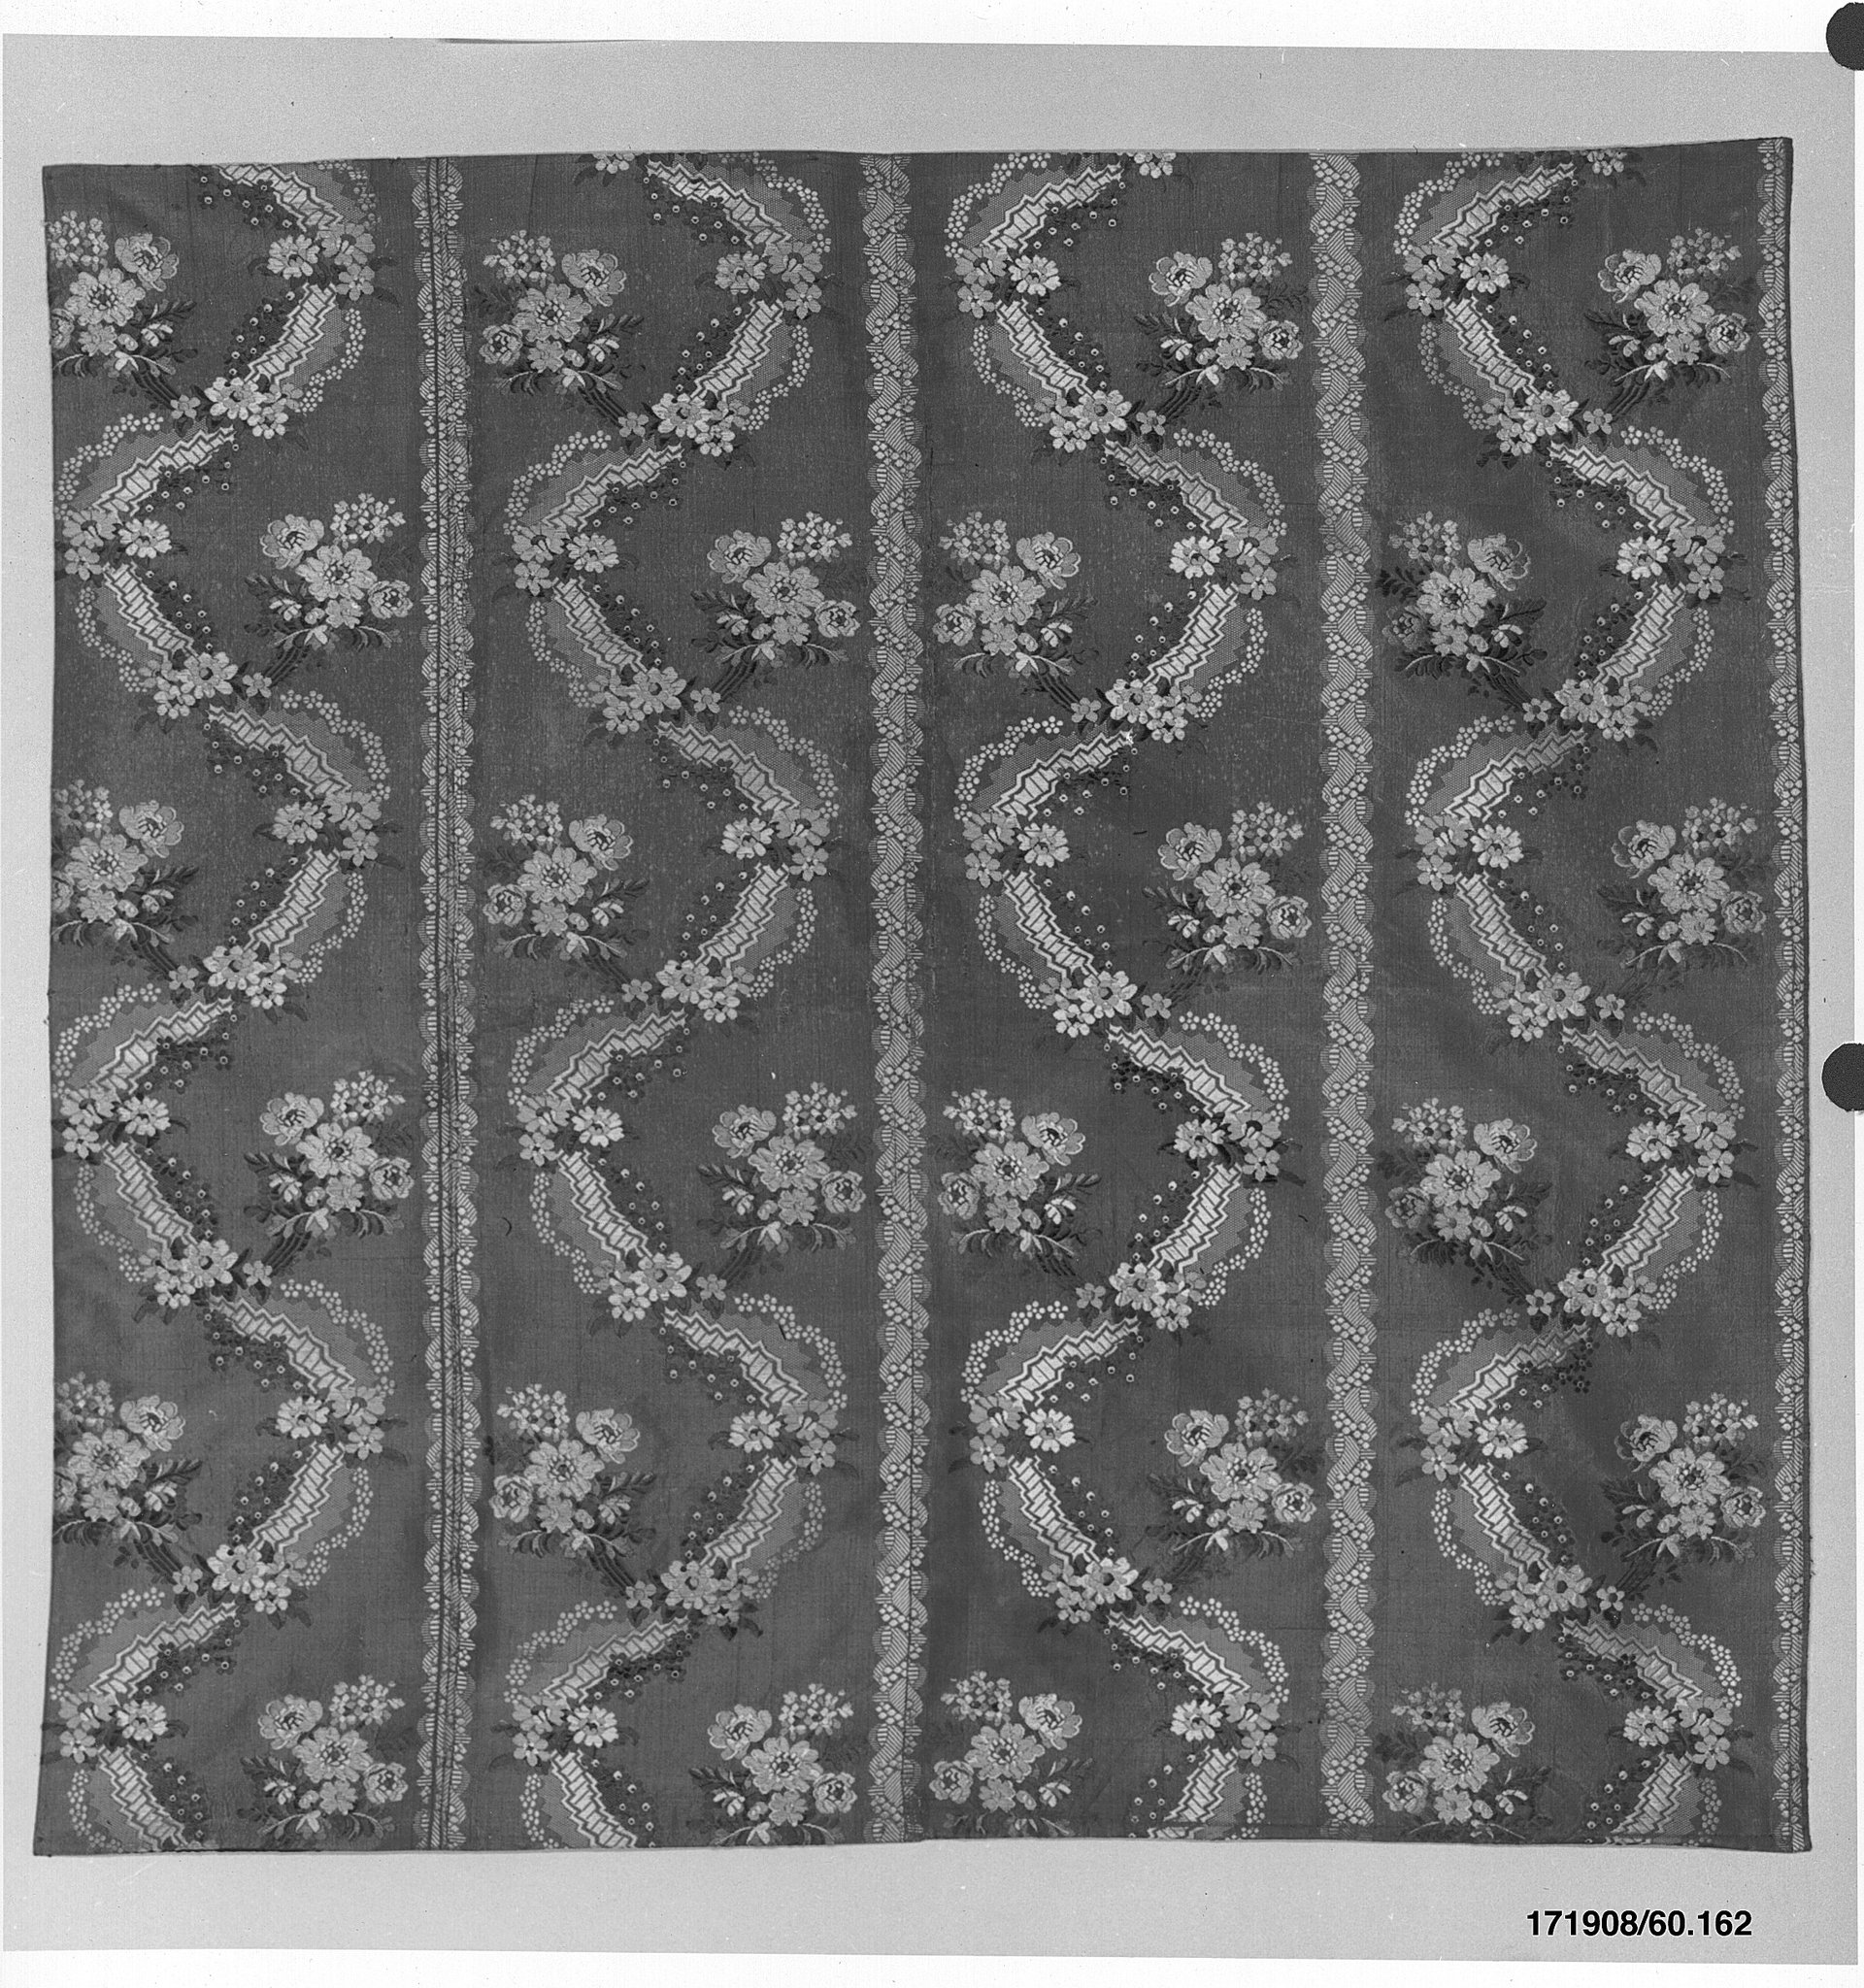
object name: piece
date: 1760-1770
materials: silk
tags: flowers